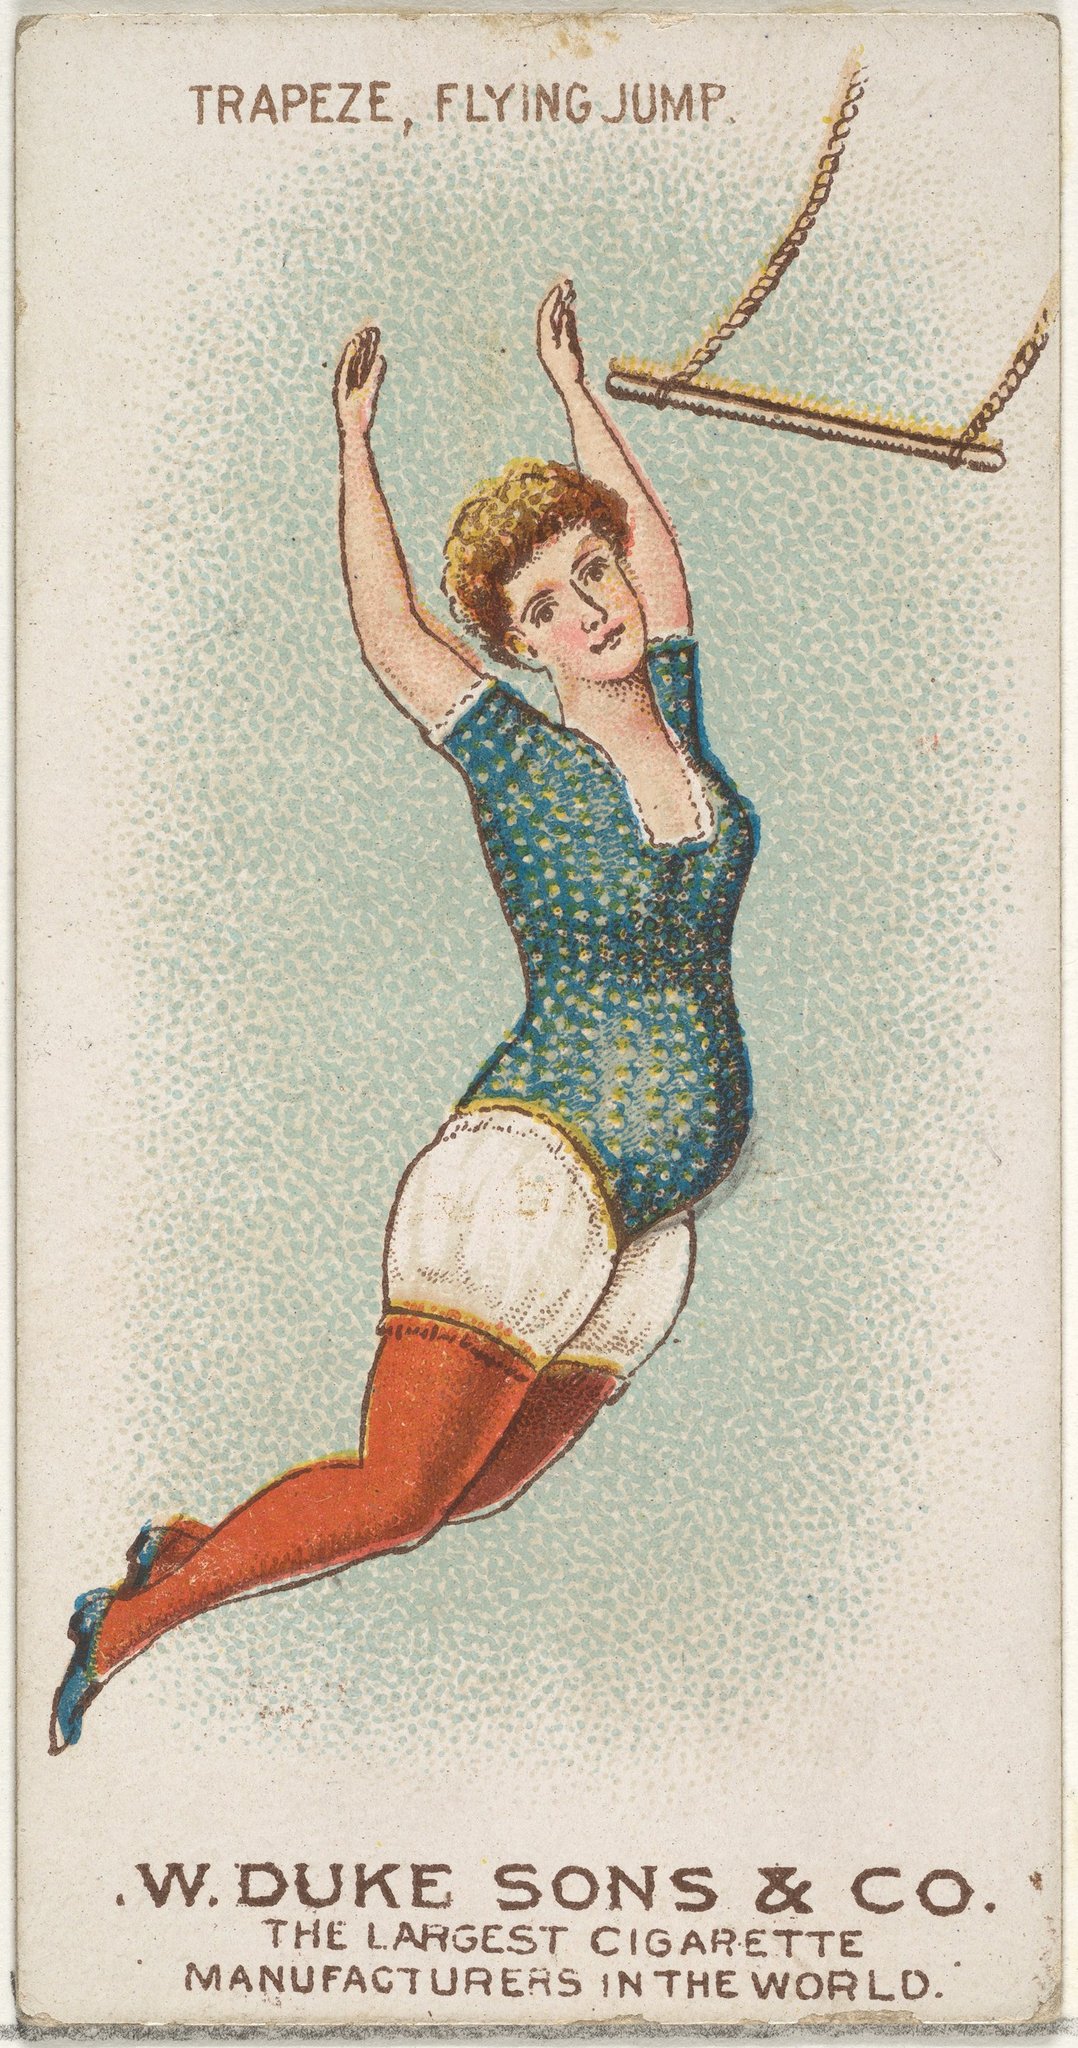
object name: print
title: Trapeze, Flying Jump, from the Gymnastic Exercises series (N77) for Duke brand cigarettes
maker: w. duke, sons & co.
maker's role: publisher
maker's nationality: american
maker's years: 1870-1920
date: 1887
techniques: color lithograph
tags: women,athletes